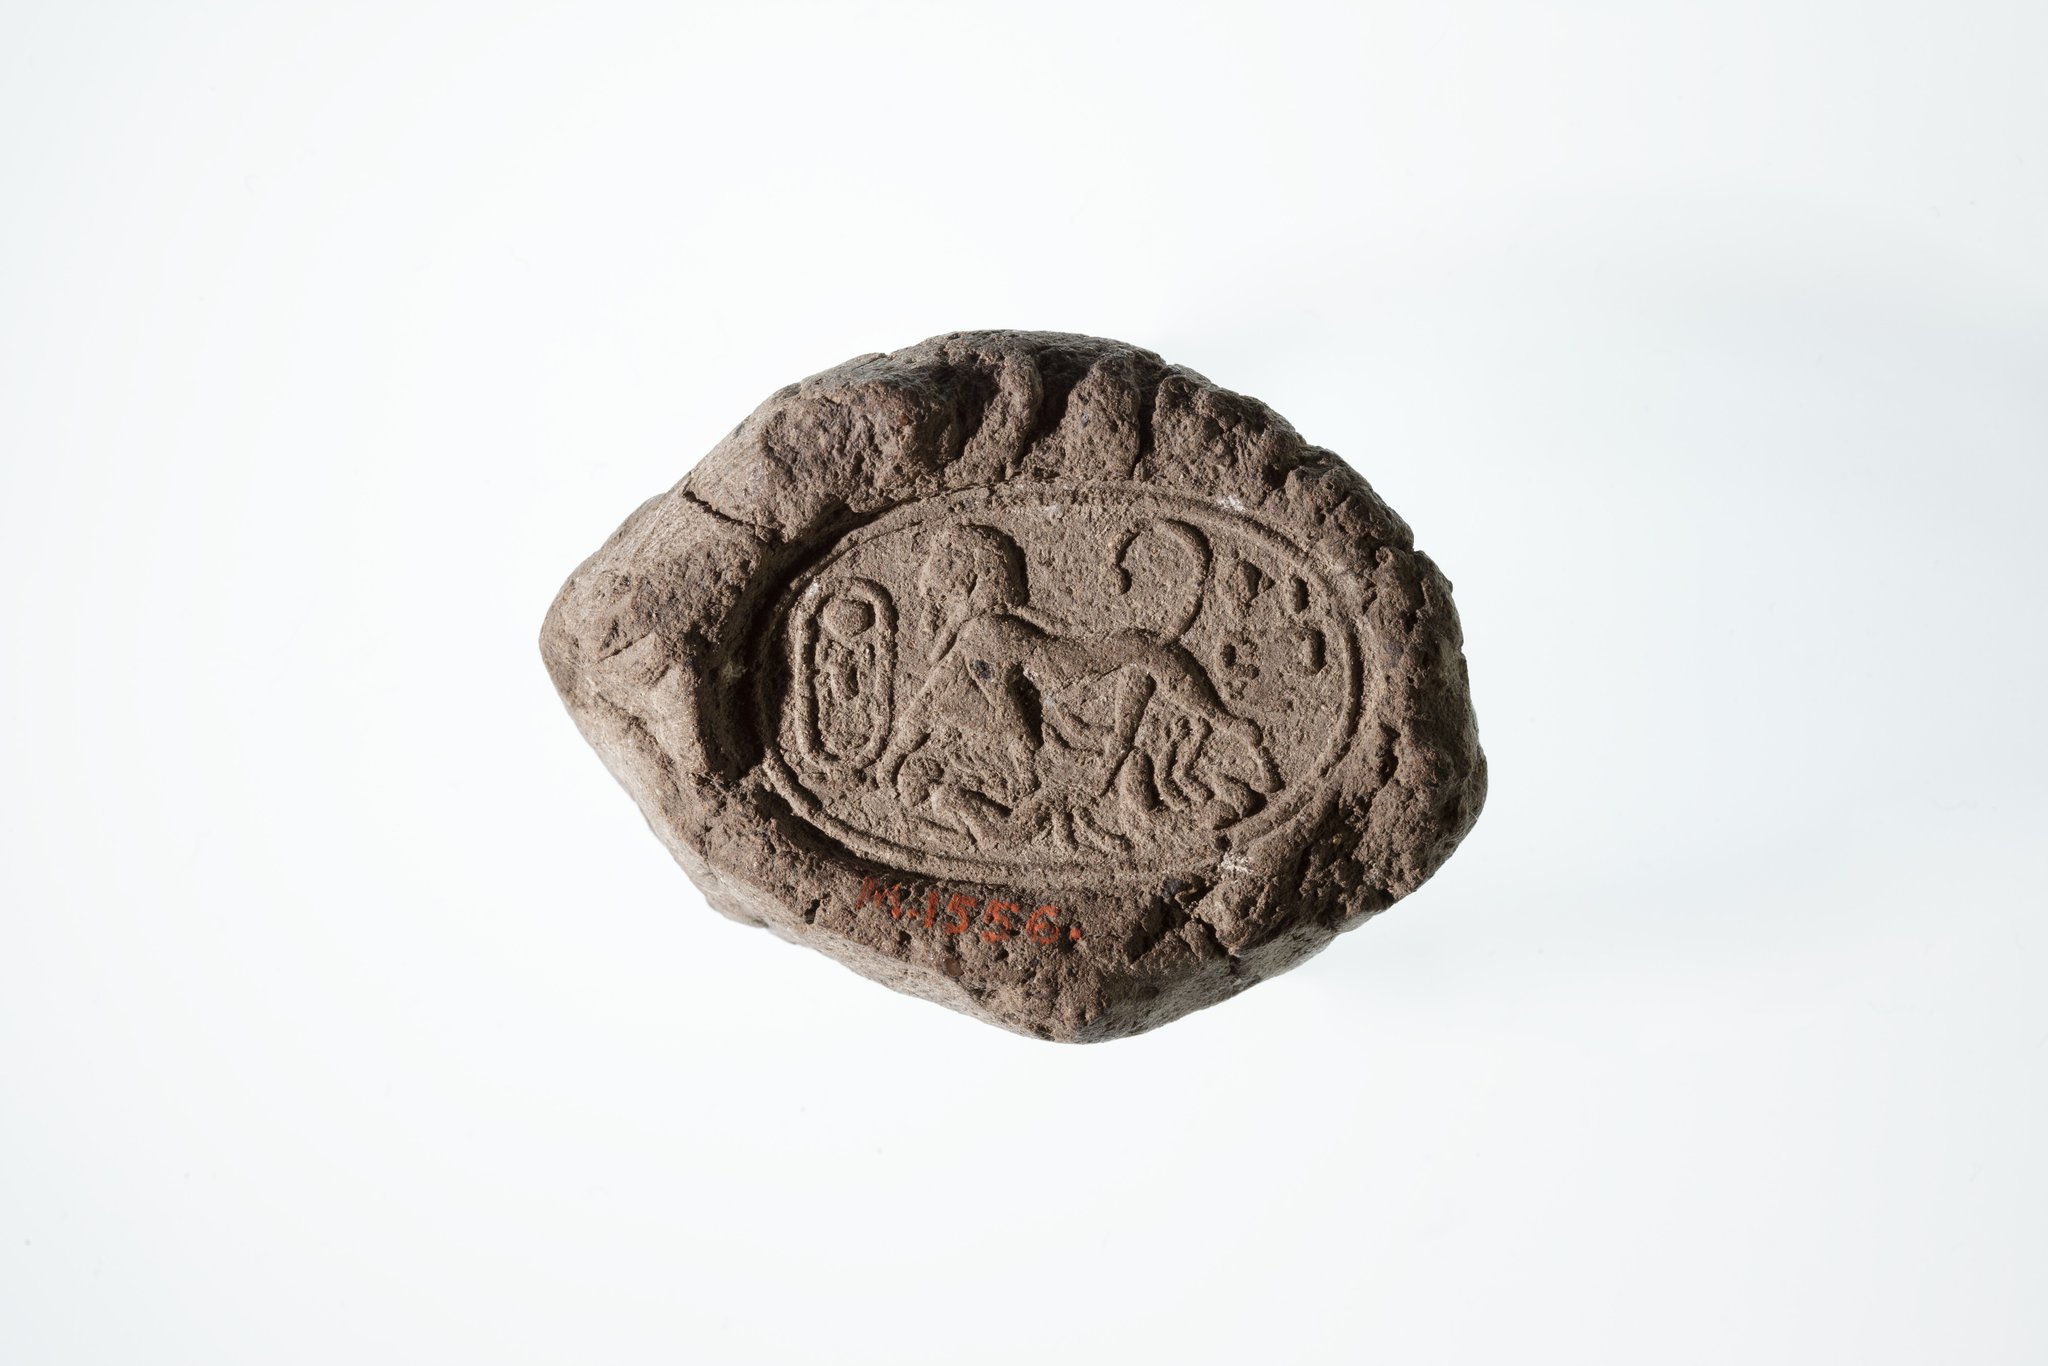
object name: seal impression, rampant sphinx, tutankhamun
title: Seal impression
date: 1336-1327 BCE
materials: clay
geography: egypt